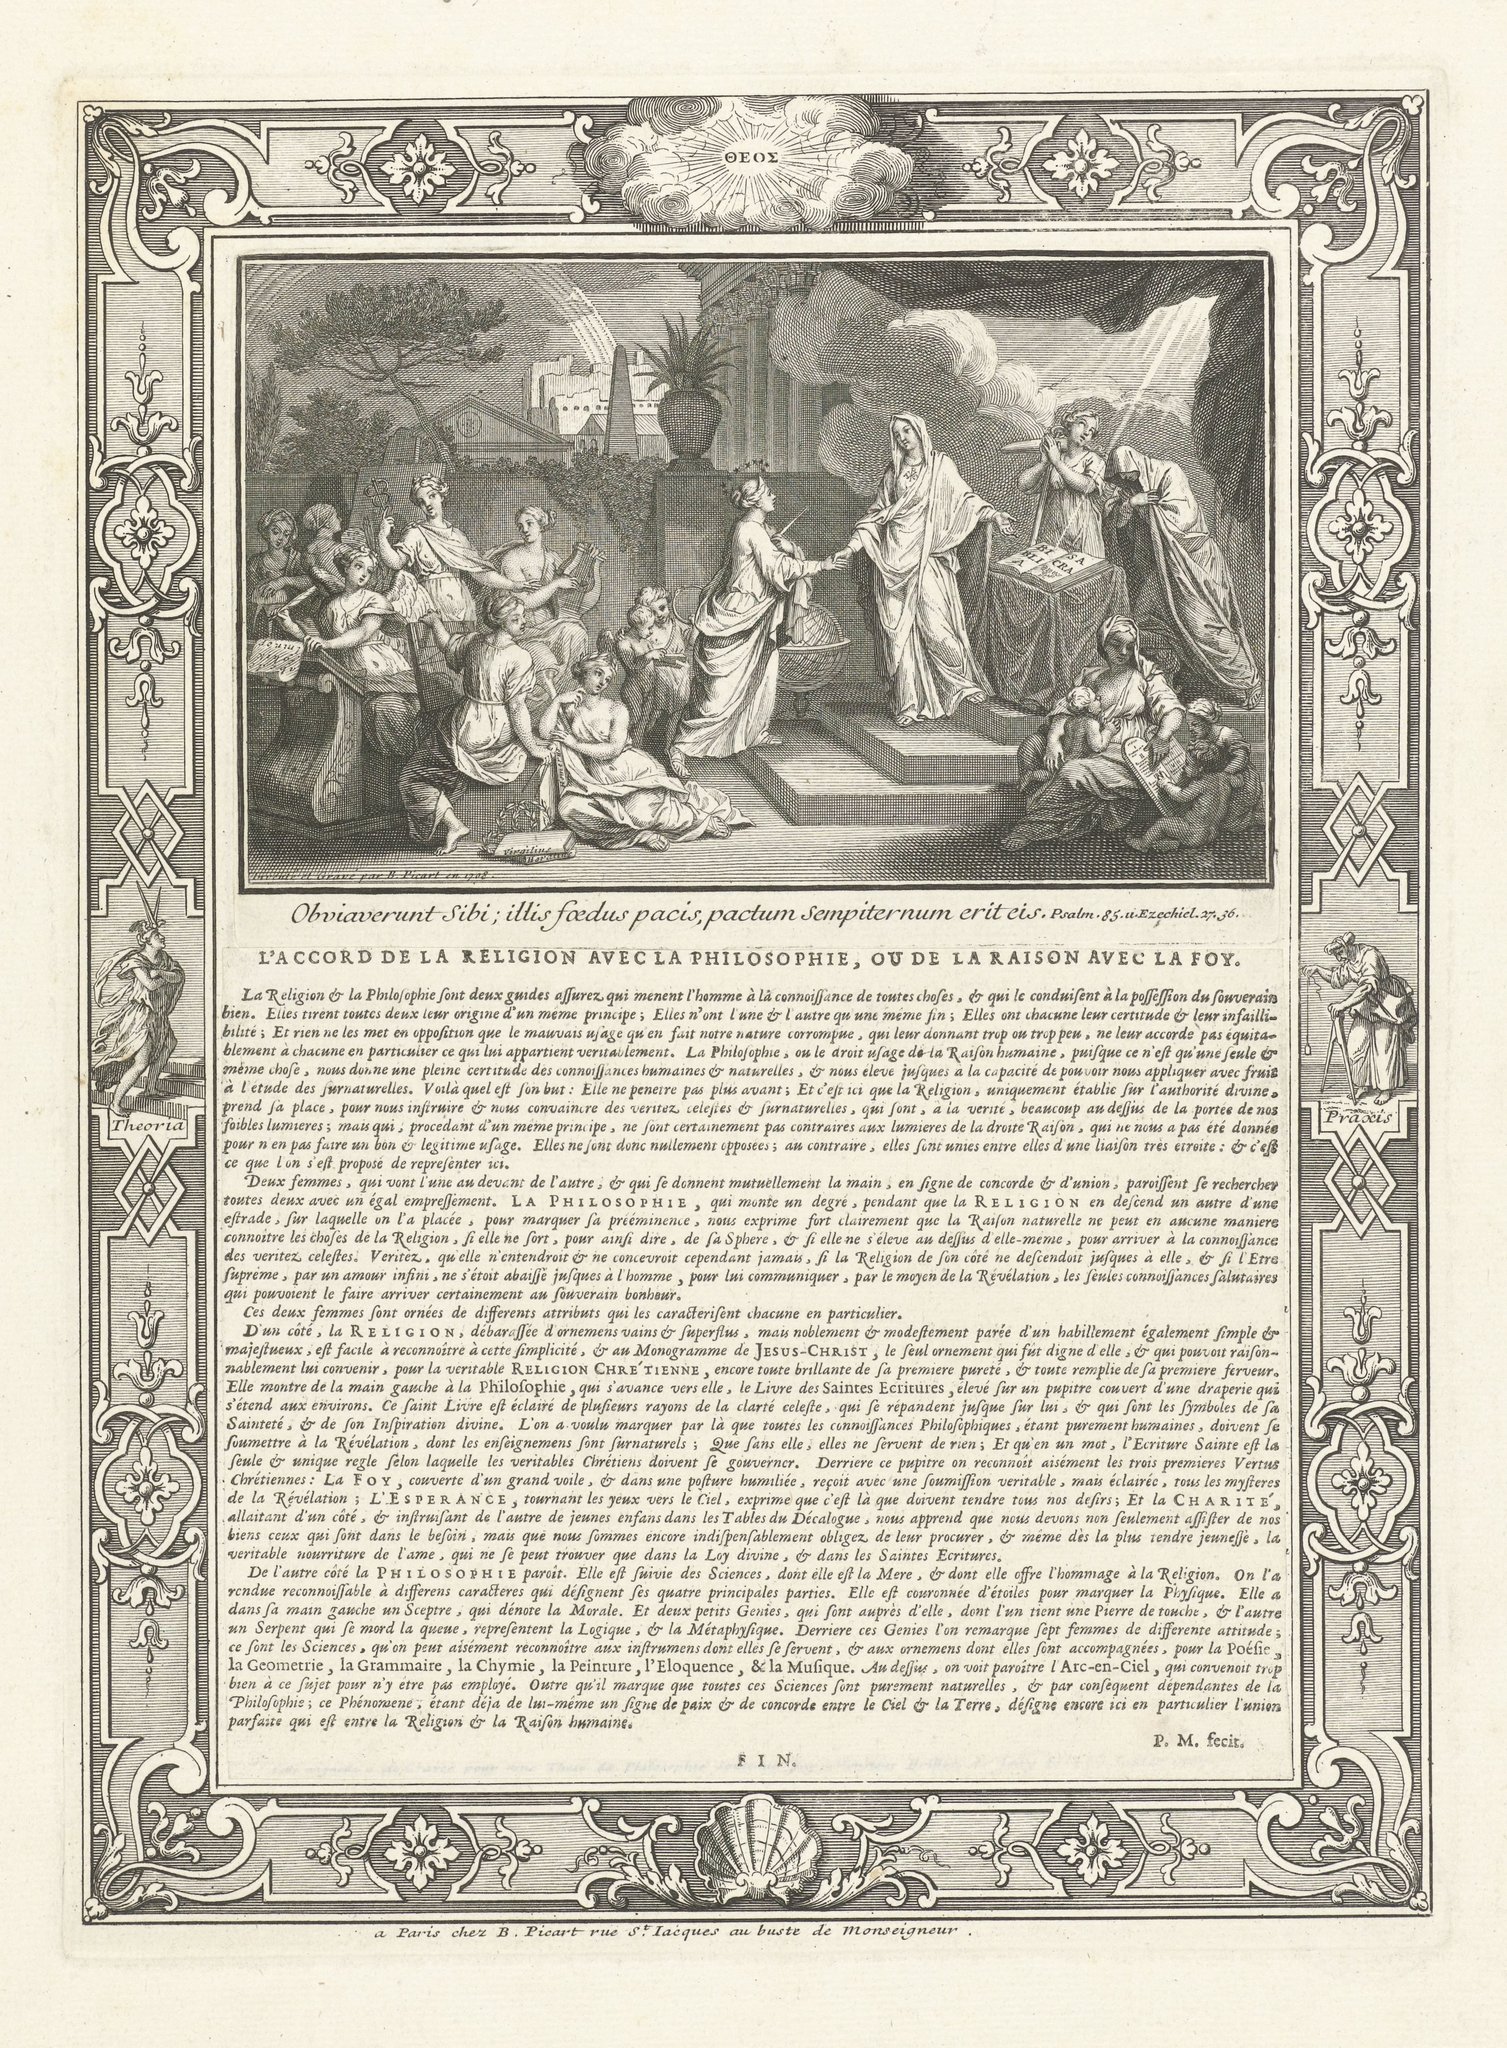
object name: print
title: L'accord de la religion avec la philosophie, ou de la raison avec la foy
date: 1708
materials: paper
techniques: engraving, etching, letterpress printing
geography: paris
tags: greek script, charity, 'caritas'; 'carità' (ripa) ~ one of the three theological virtues, faith, 'fides'; 'fede', 'fede catholica', 'fede christiana', 'fede christiana catholica' (ripa) ~ one of the three theological virtues, hope, 'spes'; 'speranza divina e certa' (ripa) ~ one of the three theological virtues, practice; 'prattica' (ripa), reason; 'ragione' (ripa) (+ symbolical representation of concept), the liberal arts together with other disciplines, 'philosophia'; 'filosofia' (ripa), allegorical and symbolical representations ~ the church and religion, theory; 'theoria' (ripa)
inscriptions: collector's mark: Lugt 2228, number: ‘28’, collector's mark: Lugt 240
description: Prent met een allegorische voorstelling die is verschenen voor een these filosofie van een onbekende persoon. De gepersonifieerde Filosofie, met een krans van sterren boven het hoofd, schudt de hand van Religie, die op de bijbel wijst. Achter hen staan Hoop (Spes) en Geloof (Fides). Rechts op de voorgrond Liefde (Caritas) die kinderen wijst op de tafelen der wet. Links de vrouwlijke personificaties van de zeven vrije kunsten. In de marge een Bijbelcitaat in het Latijn. Onder de voorstelling een tekst in het Frans. Het geheel is gedecoreerd met een ornamentele omlijsting waarin Theorie en Praktijk.